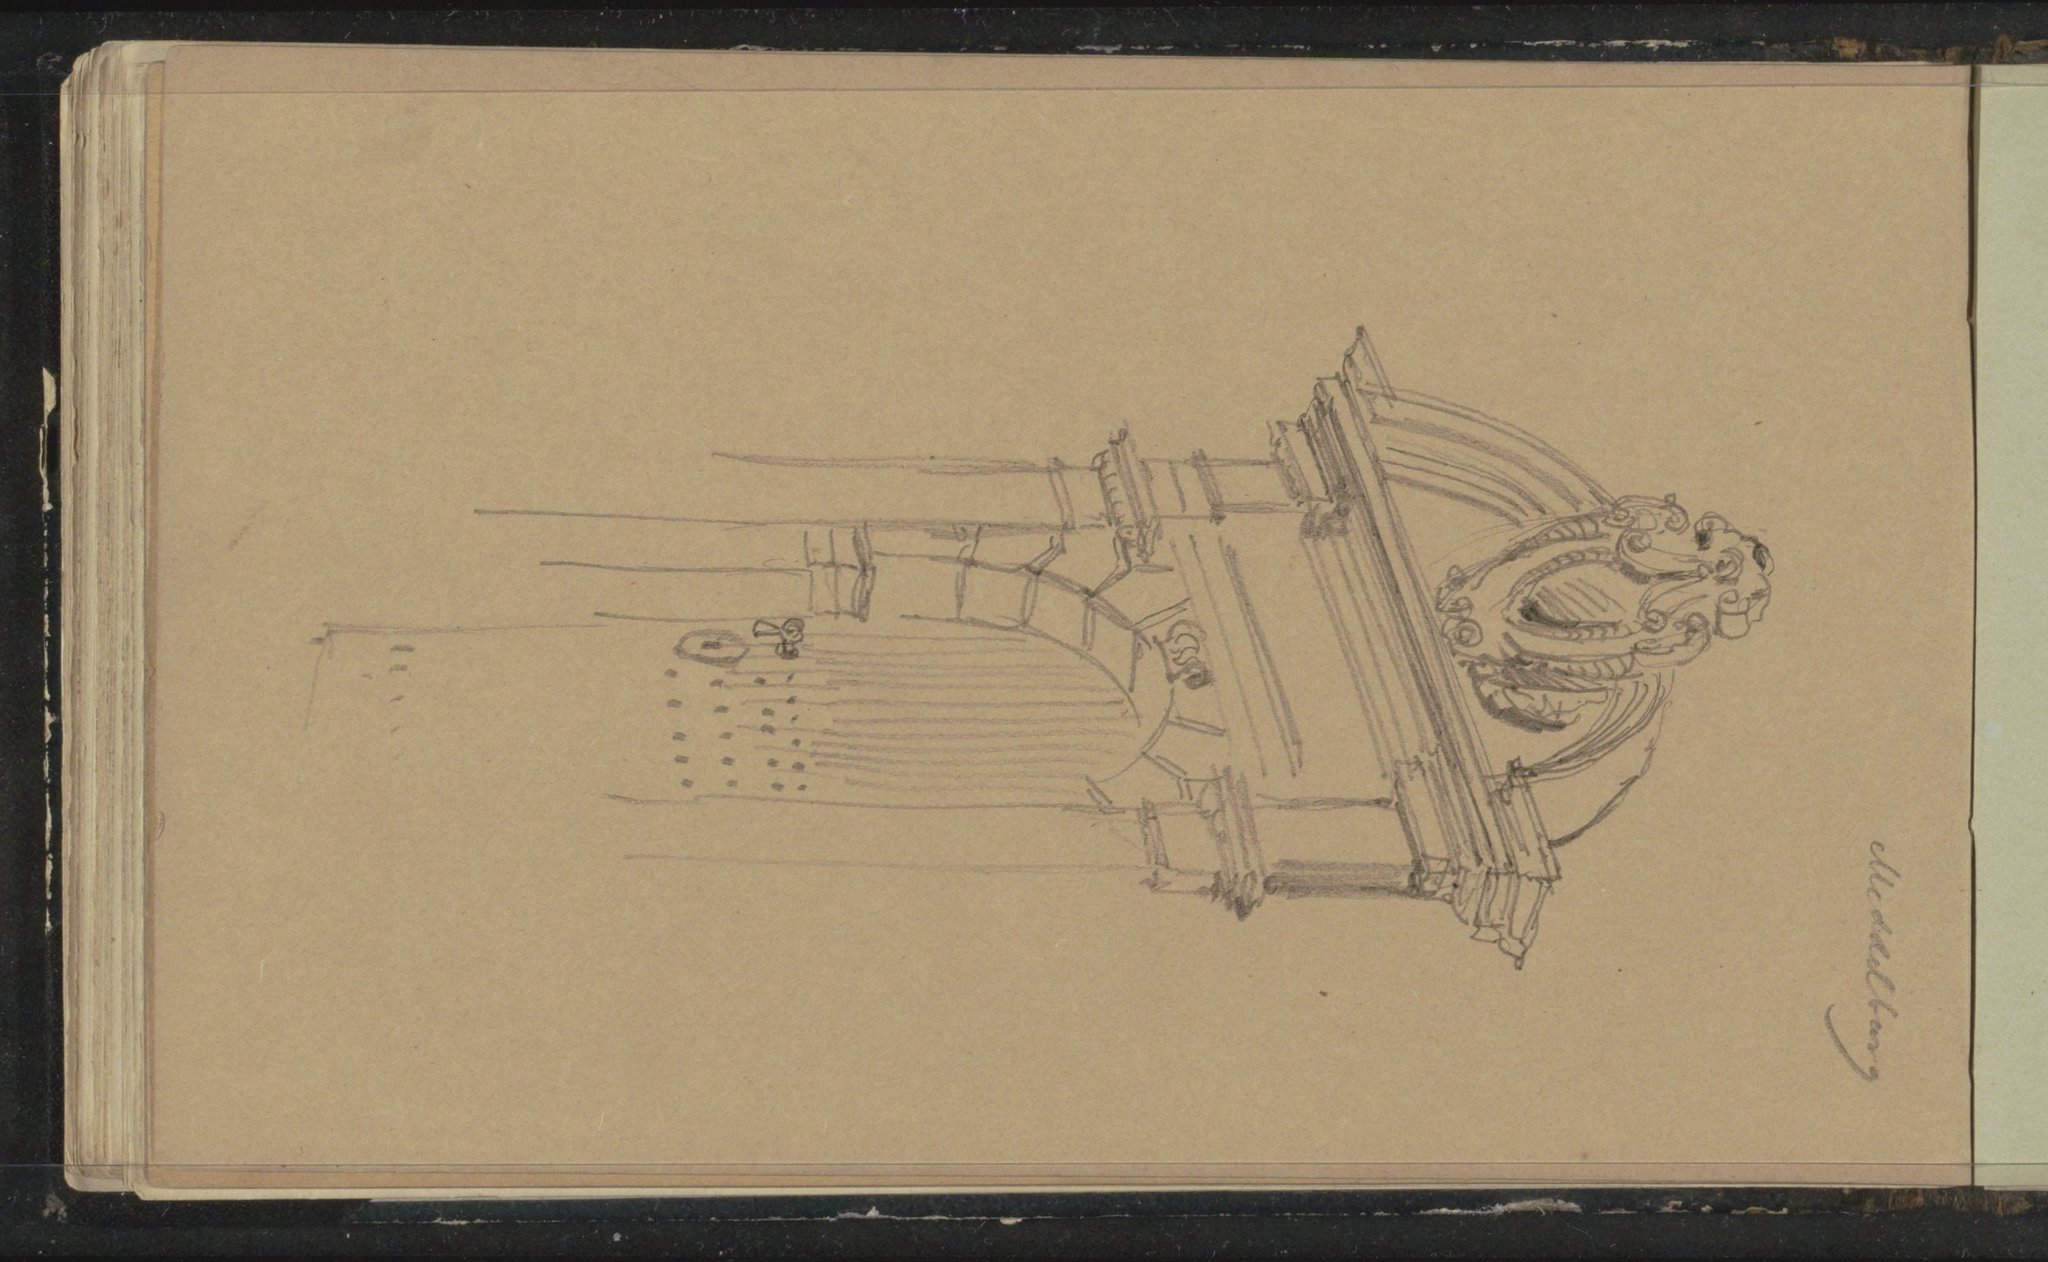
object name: sketchbook leaf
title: Poort of deur met geveldecoratie te Middelburg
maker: cornelis springer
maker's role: draughtsman, painter, print maker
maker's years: 1817-1891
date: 1856-1861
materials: paper, pencil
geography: middelburg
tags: gate, entrance, closed door, middelburg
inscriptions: annotation: ‘Middelburg’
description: Poort of deur met geveldecoratie te Middelburg. Blad 36 verso uit een schetsboek met 44 bladen vervaardigd in Zeeland en Utrecht.